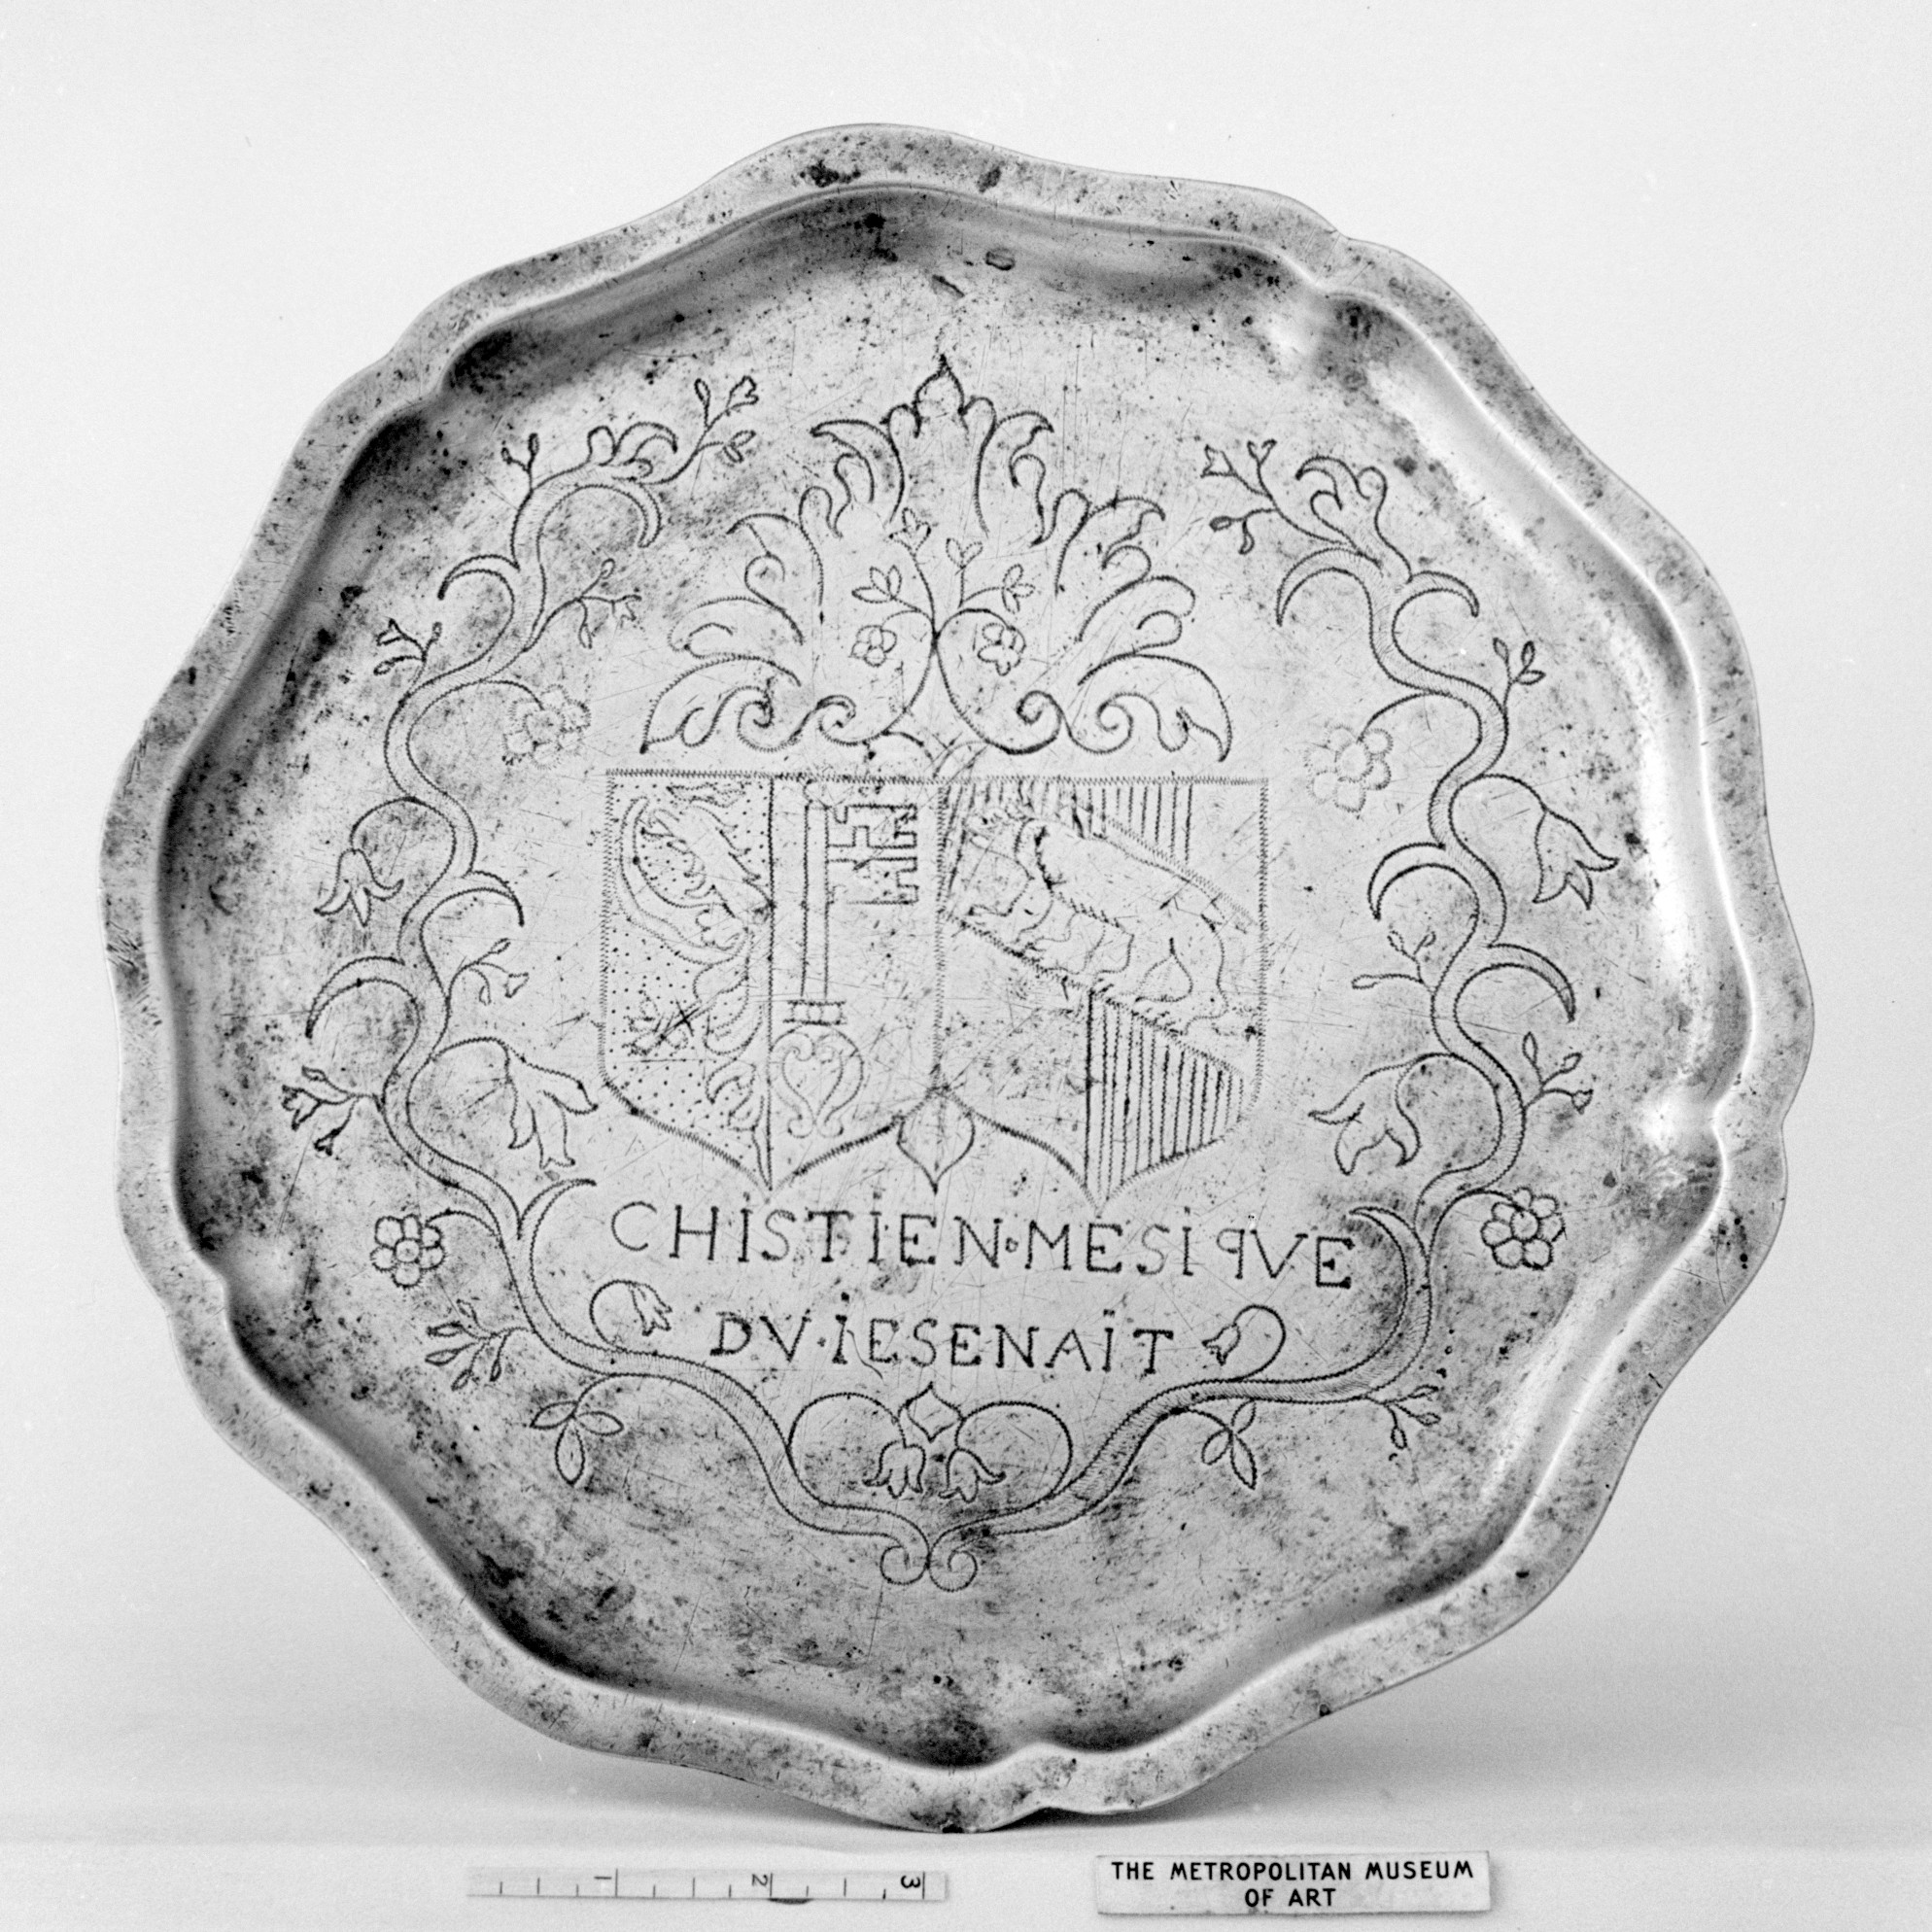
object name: salver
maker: jean charton the elder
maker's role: maker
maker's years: 1695-1778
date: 1701-1800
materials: pewter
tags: coat of arms